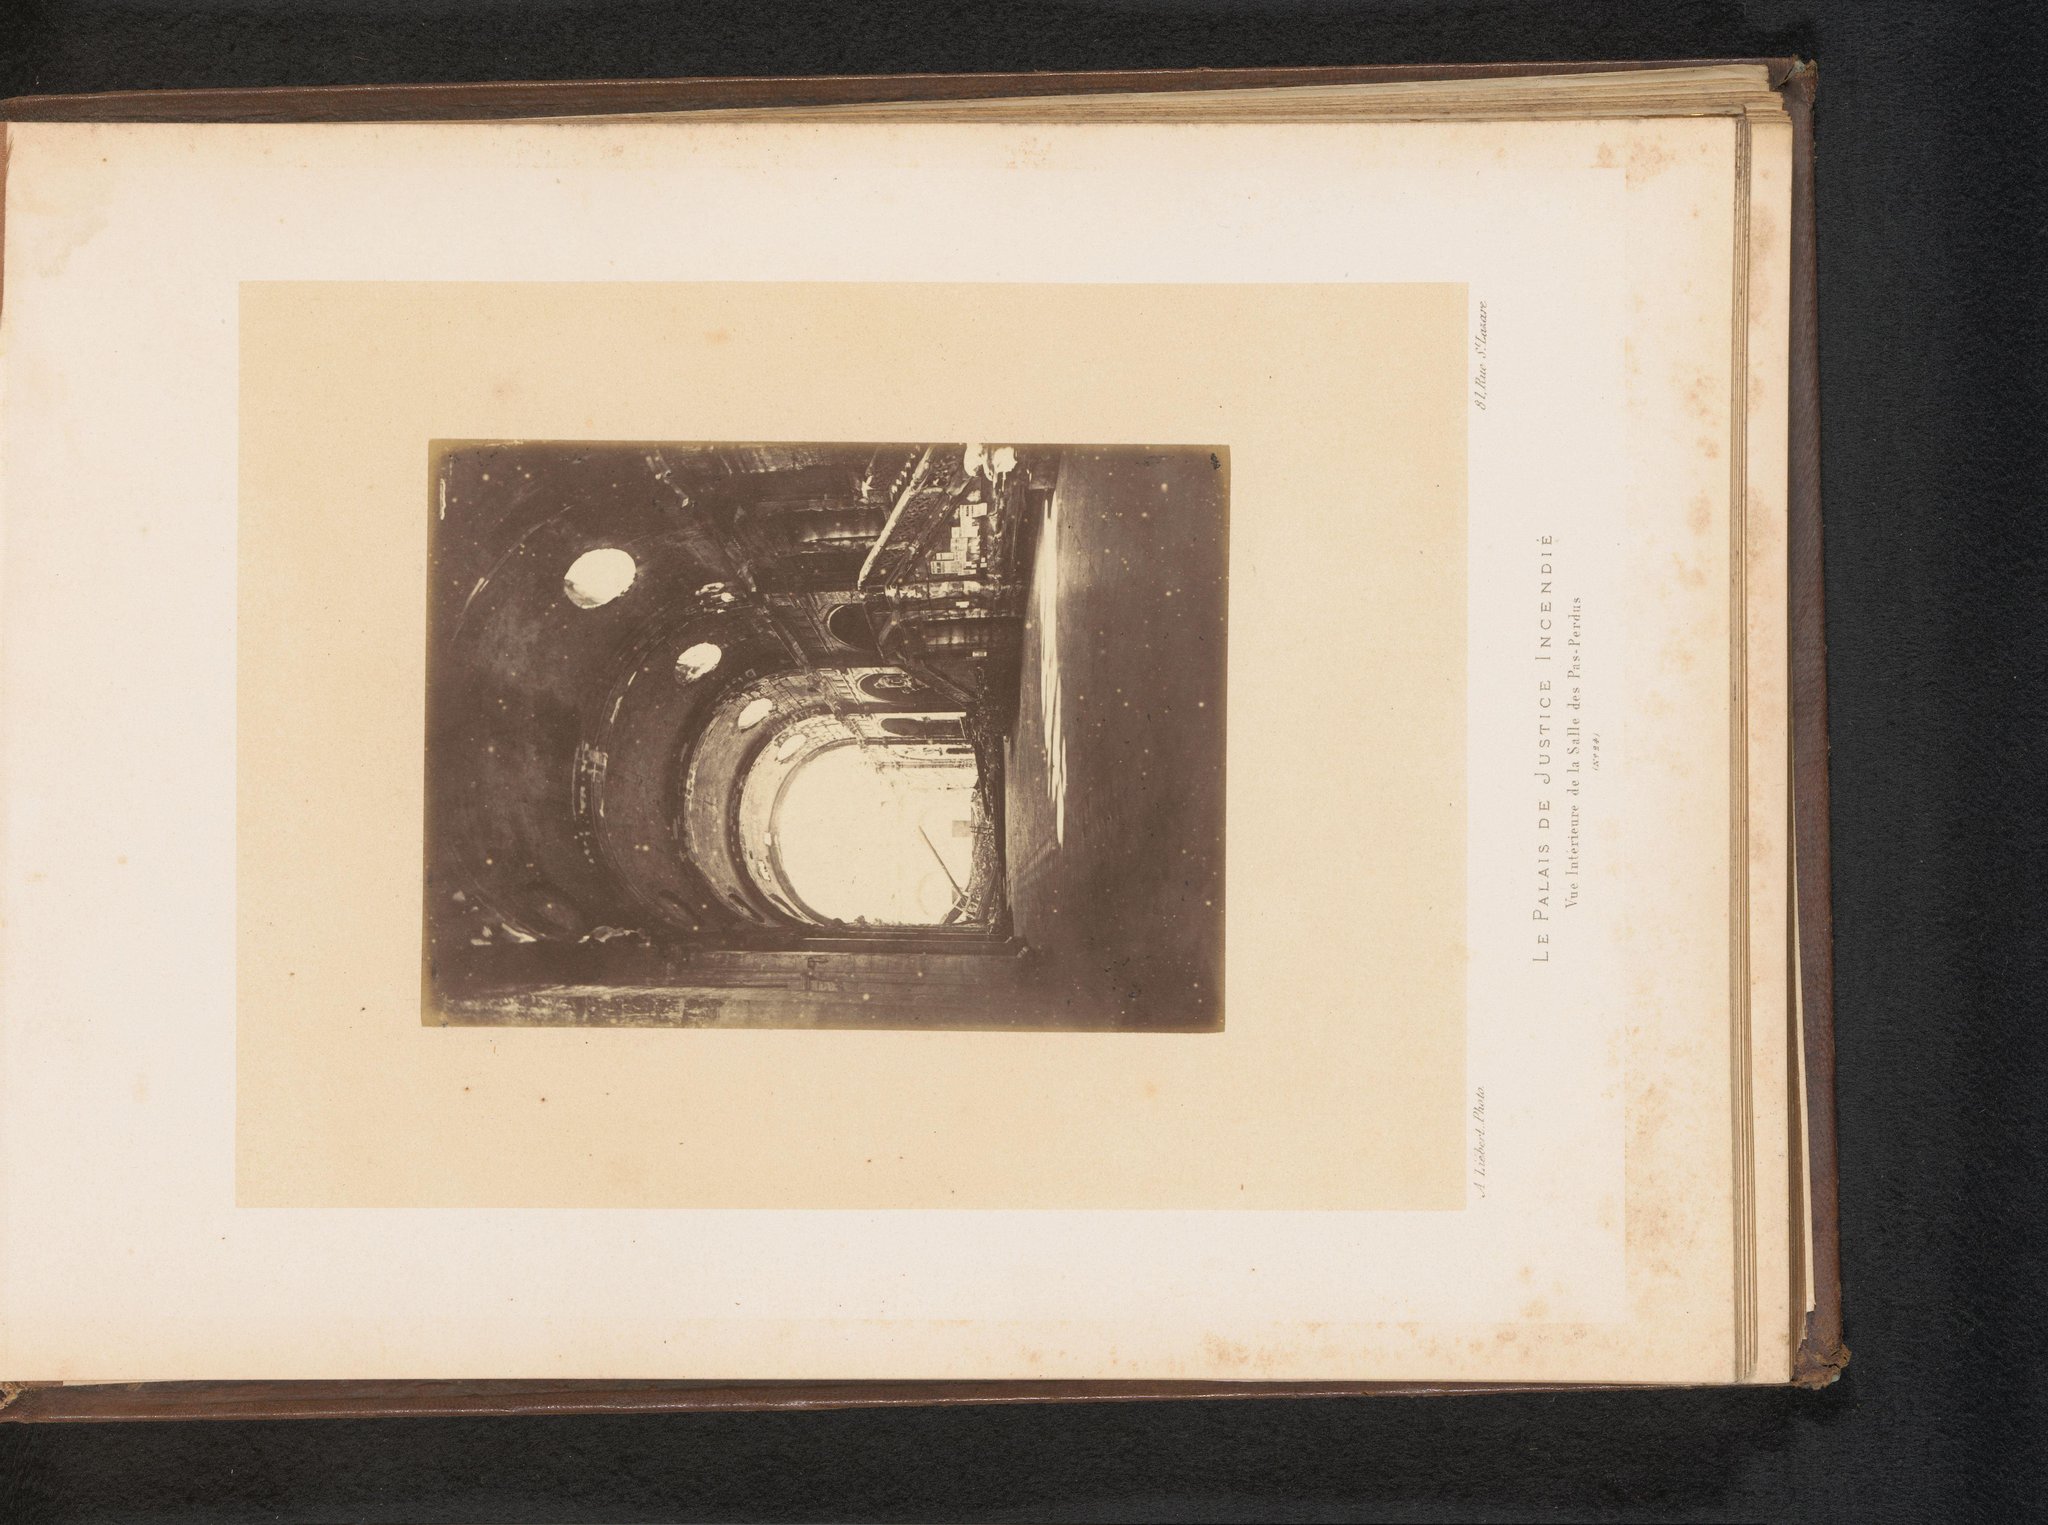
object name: page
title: Le Palais de Justice Incendié. Vue Intérieure de la Salle des Pas-Perdus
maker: alphonse-justin liébert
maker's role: fotograaf, marinier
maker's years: 1827-1914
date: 1871-1872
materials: photographic support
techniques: albumen print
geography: paris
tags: court building, ruin of a building ~ architecture, gallery (spacious corridor)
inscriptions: address: ‘31, Rue St. Lazare’, number: ‘(No. 24)’